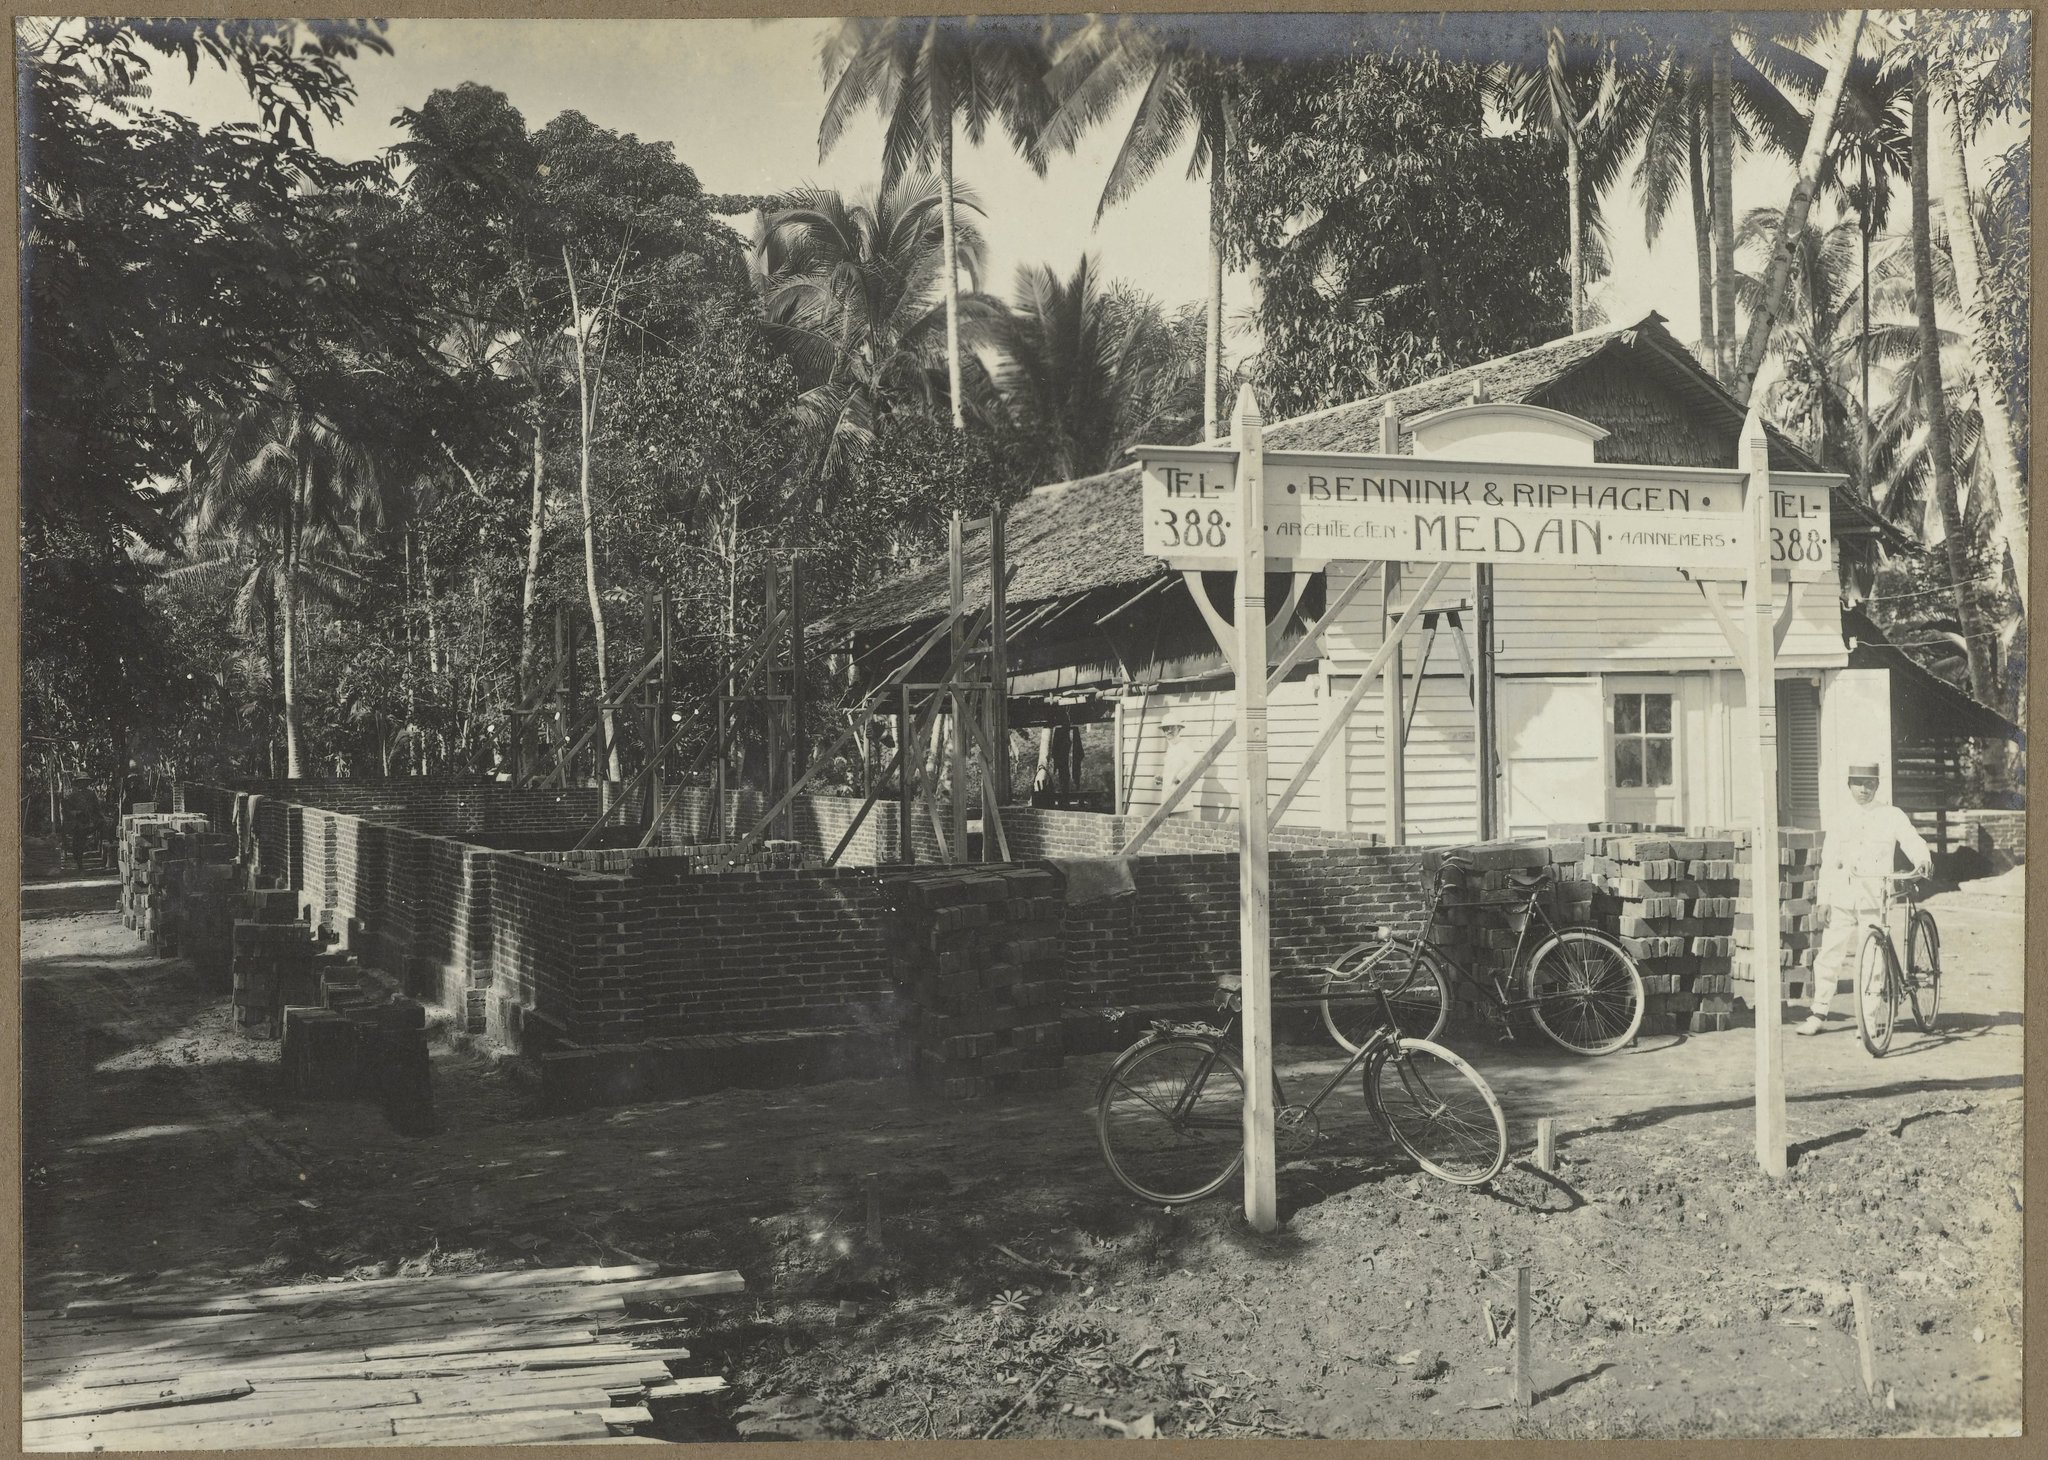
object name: photograph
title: Bouwproject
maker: Anonymous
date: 1914-1919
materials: photographic support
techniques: gelatin silver print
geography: medan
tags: making the overground structures (~ building activities), representation of real building (either existing or having existed), architecture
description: Een bouwproject, waarschijnlijk te Medan. Bij de eerste gemetselde muren een bord van het bouwbedrijf en enkele fietsen. Foto in het fotoalbum van het Nederlandse architectenbureau en aannemersbedrijf Bennink en Riphagen te Medan in de jaren ca. 1914-1919.